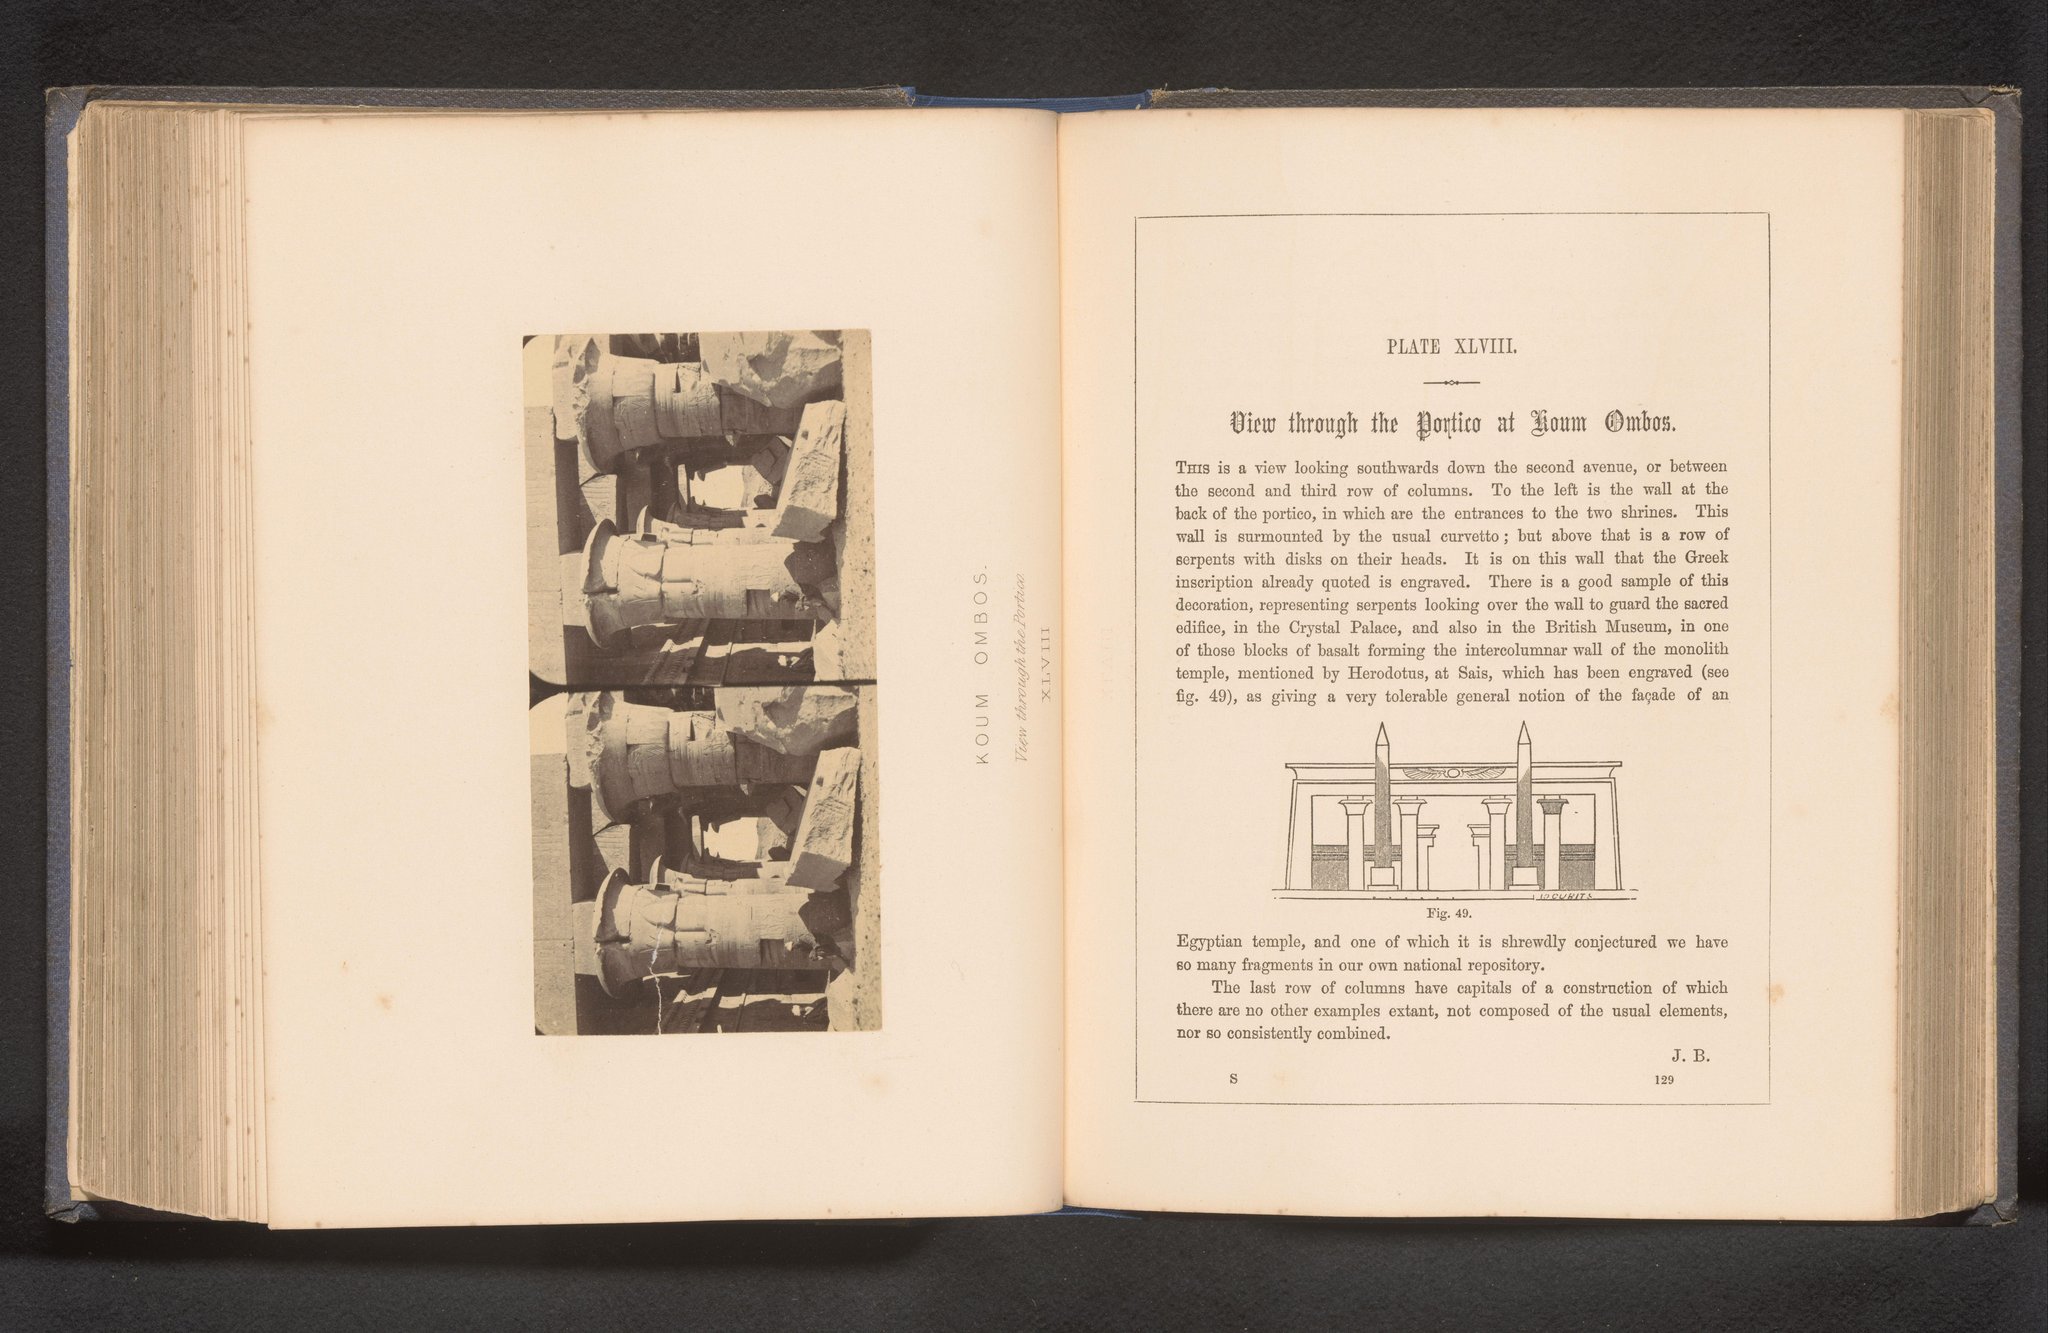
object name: page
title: Portico van de tempel van Kom Ombo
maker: francis frith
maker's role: publisher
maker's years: 1822-1898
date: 1857-1862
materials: photographic support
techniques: albumen print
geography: kom ombo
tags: temple, shrine ~ egyptian religion, ruin of a building ~ architecture, capital (~ column, pillar), egyptian hieroglyphs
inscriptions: name: ‘Frith’, number: ‘XLIVIII’, inscription: ‘View through the Portico’